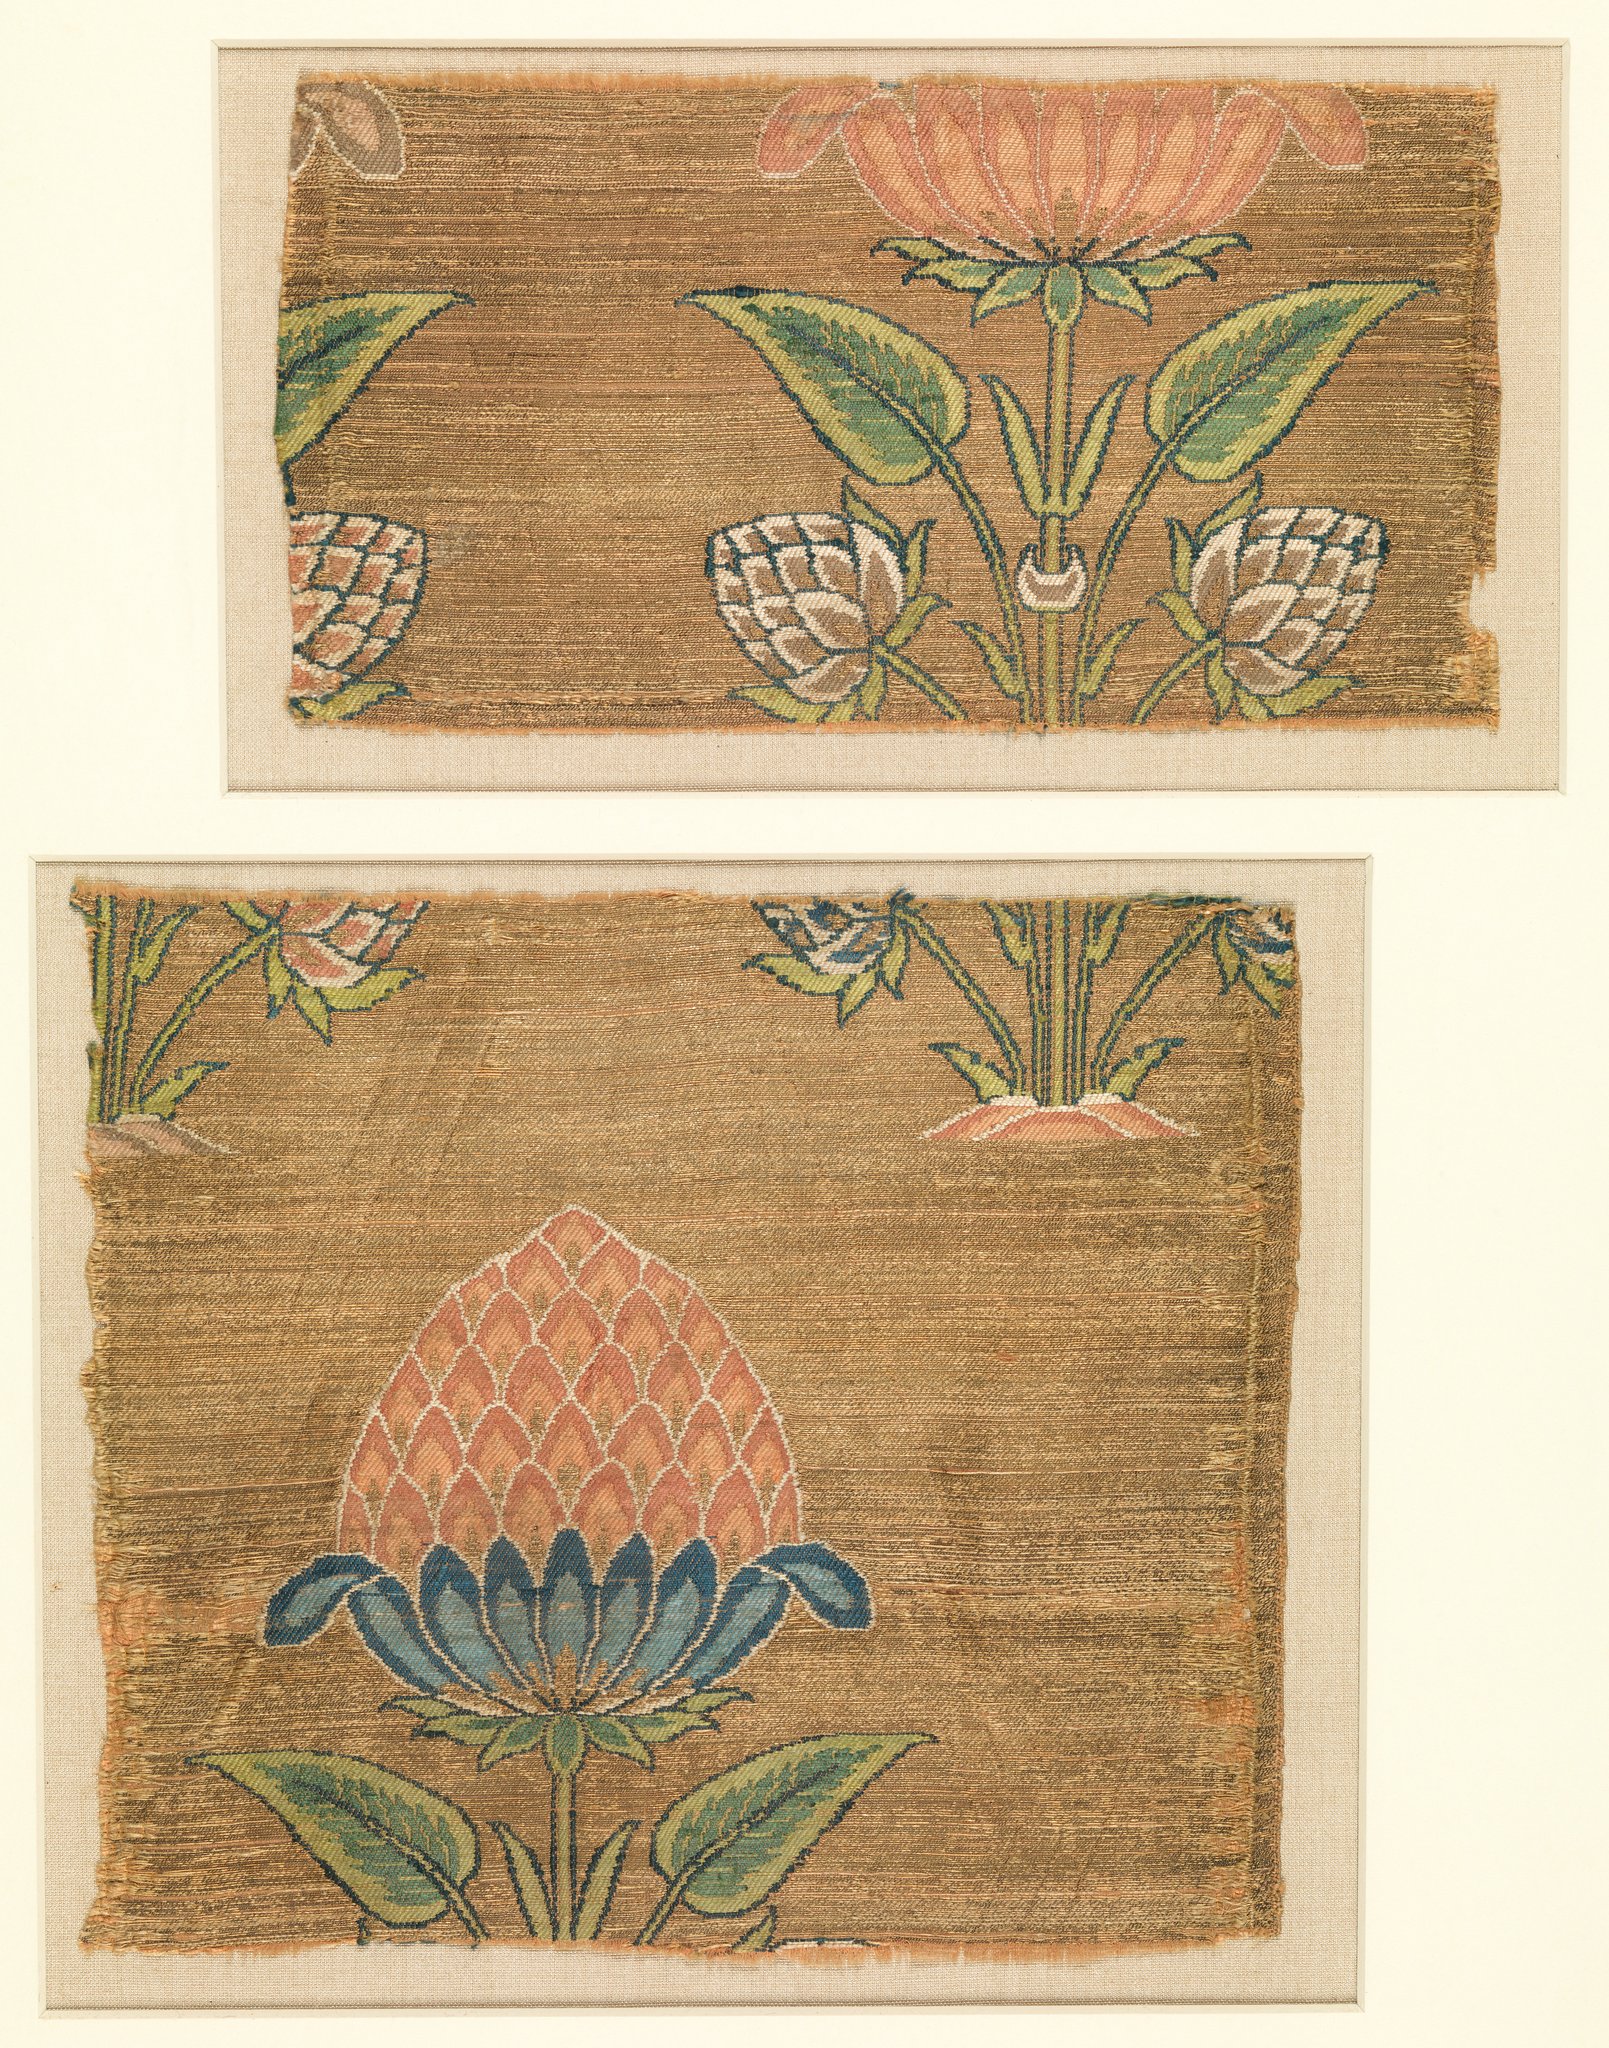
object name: textile fragment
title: Textile Fragments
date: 1601-1700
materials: silk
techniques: brocade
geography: india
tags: flowers,leaves